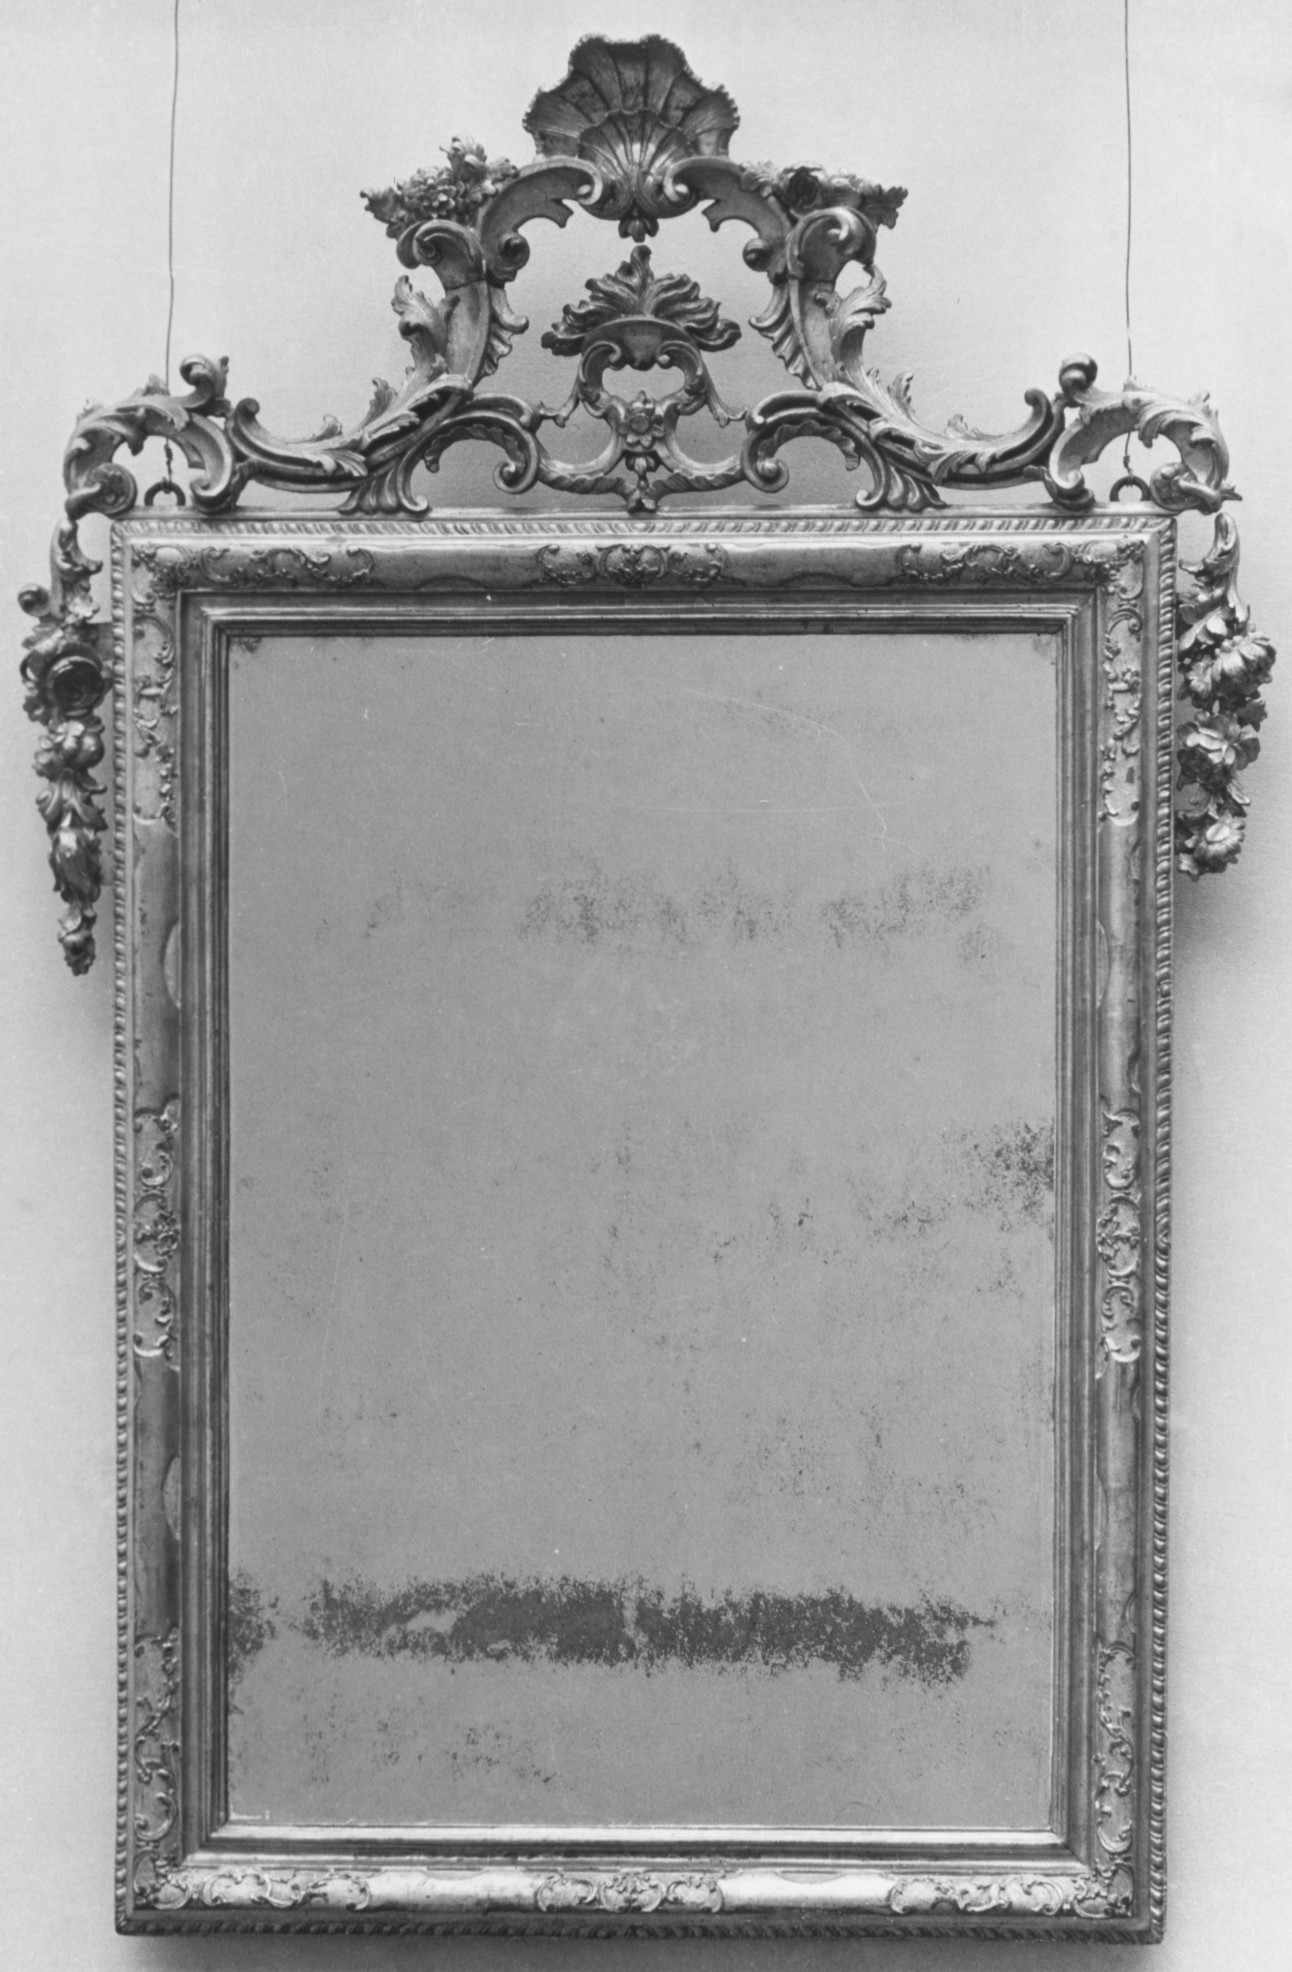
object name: mirror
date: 1701-1733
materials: wood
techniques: carving, gilding